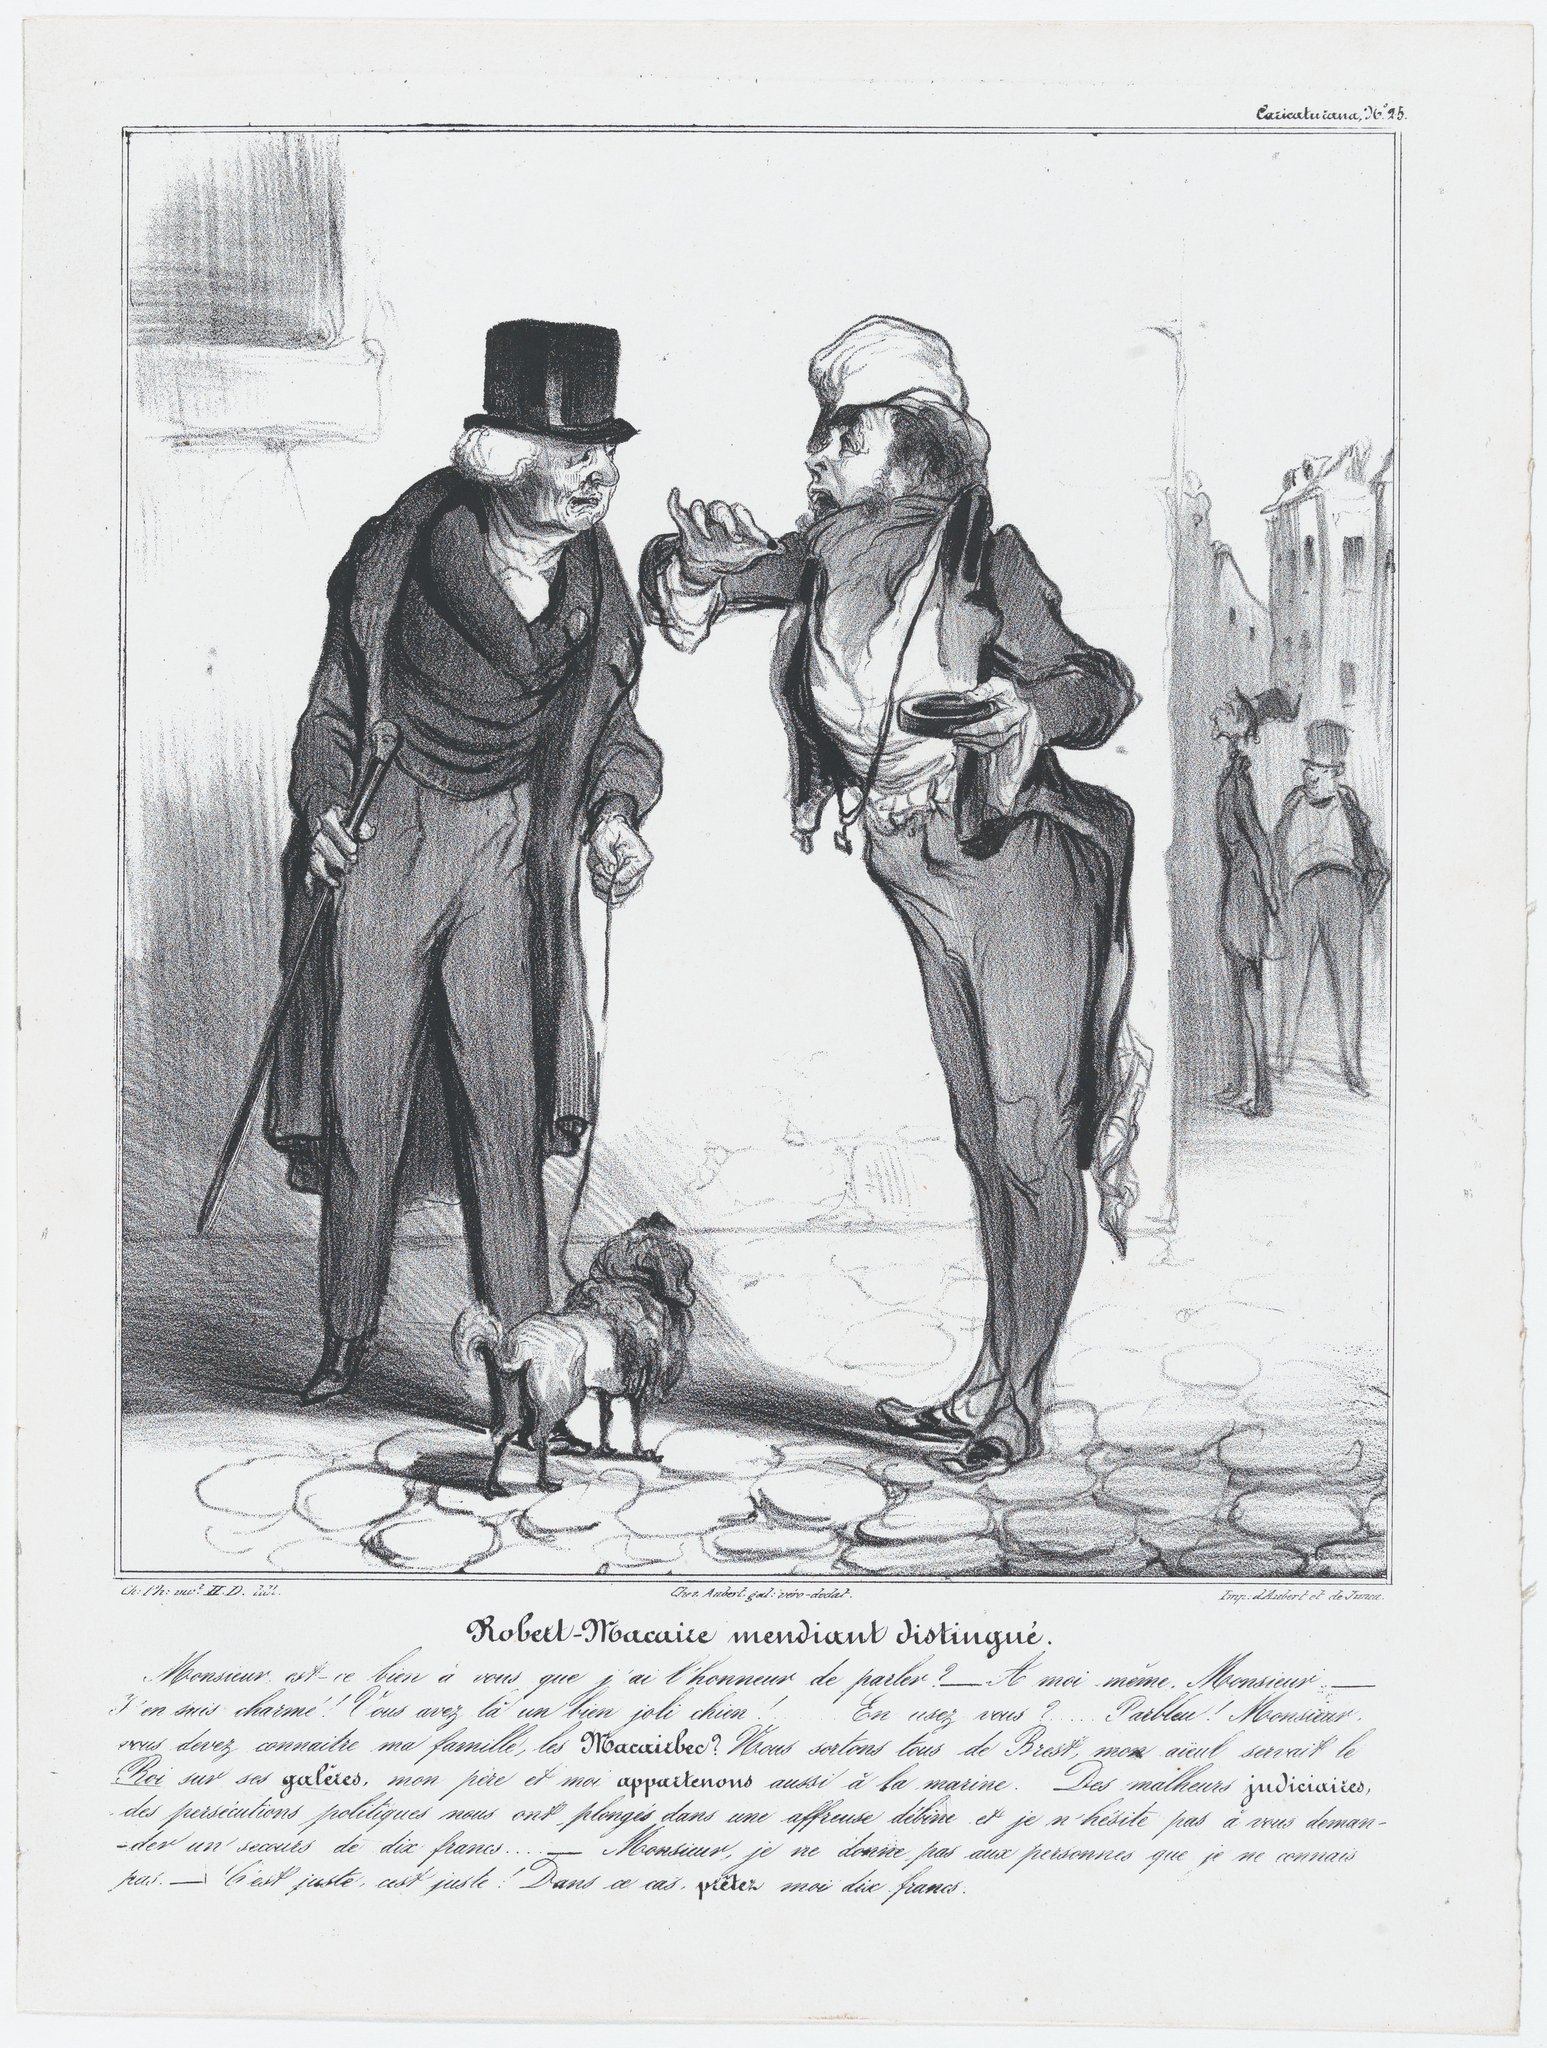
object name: print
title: Plate 25: Robert Macaire, the genteel beggar, from 'Caricaturana,' published in Les Robert Macaires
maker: honoré daumier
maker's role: artist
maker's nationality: french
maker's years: 1808-1879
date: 1838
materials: paper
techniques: lithograph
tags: satire,men